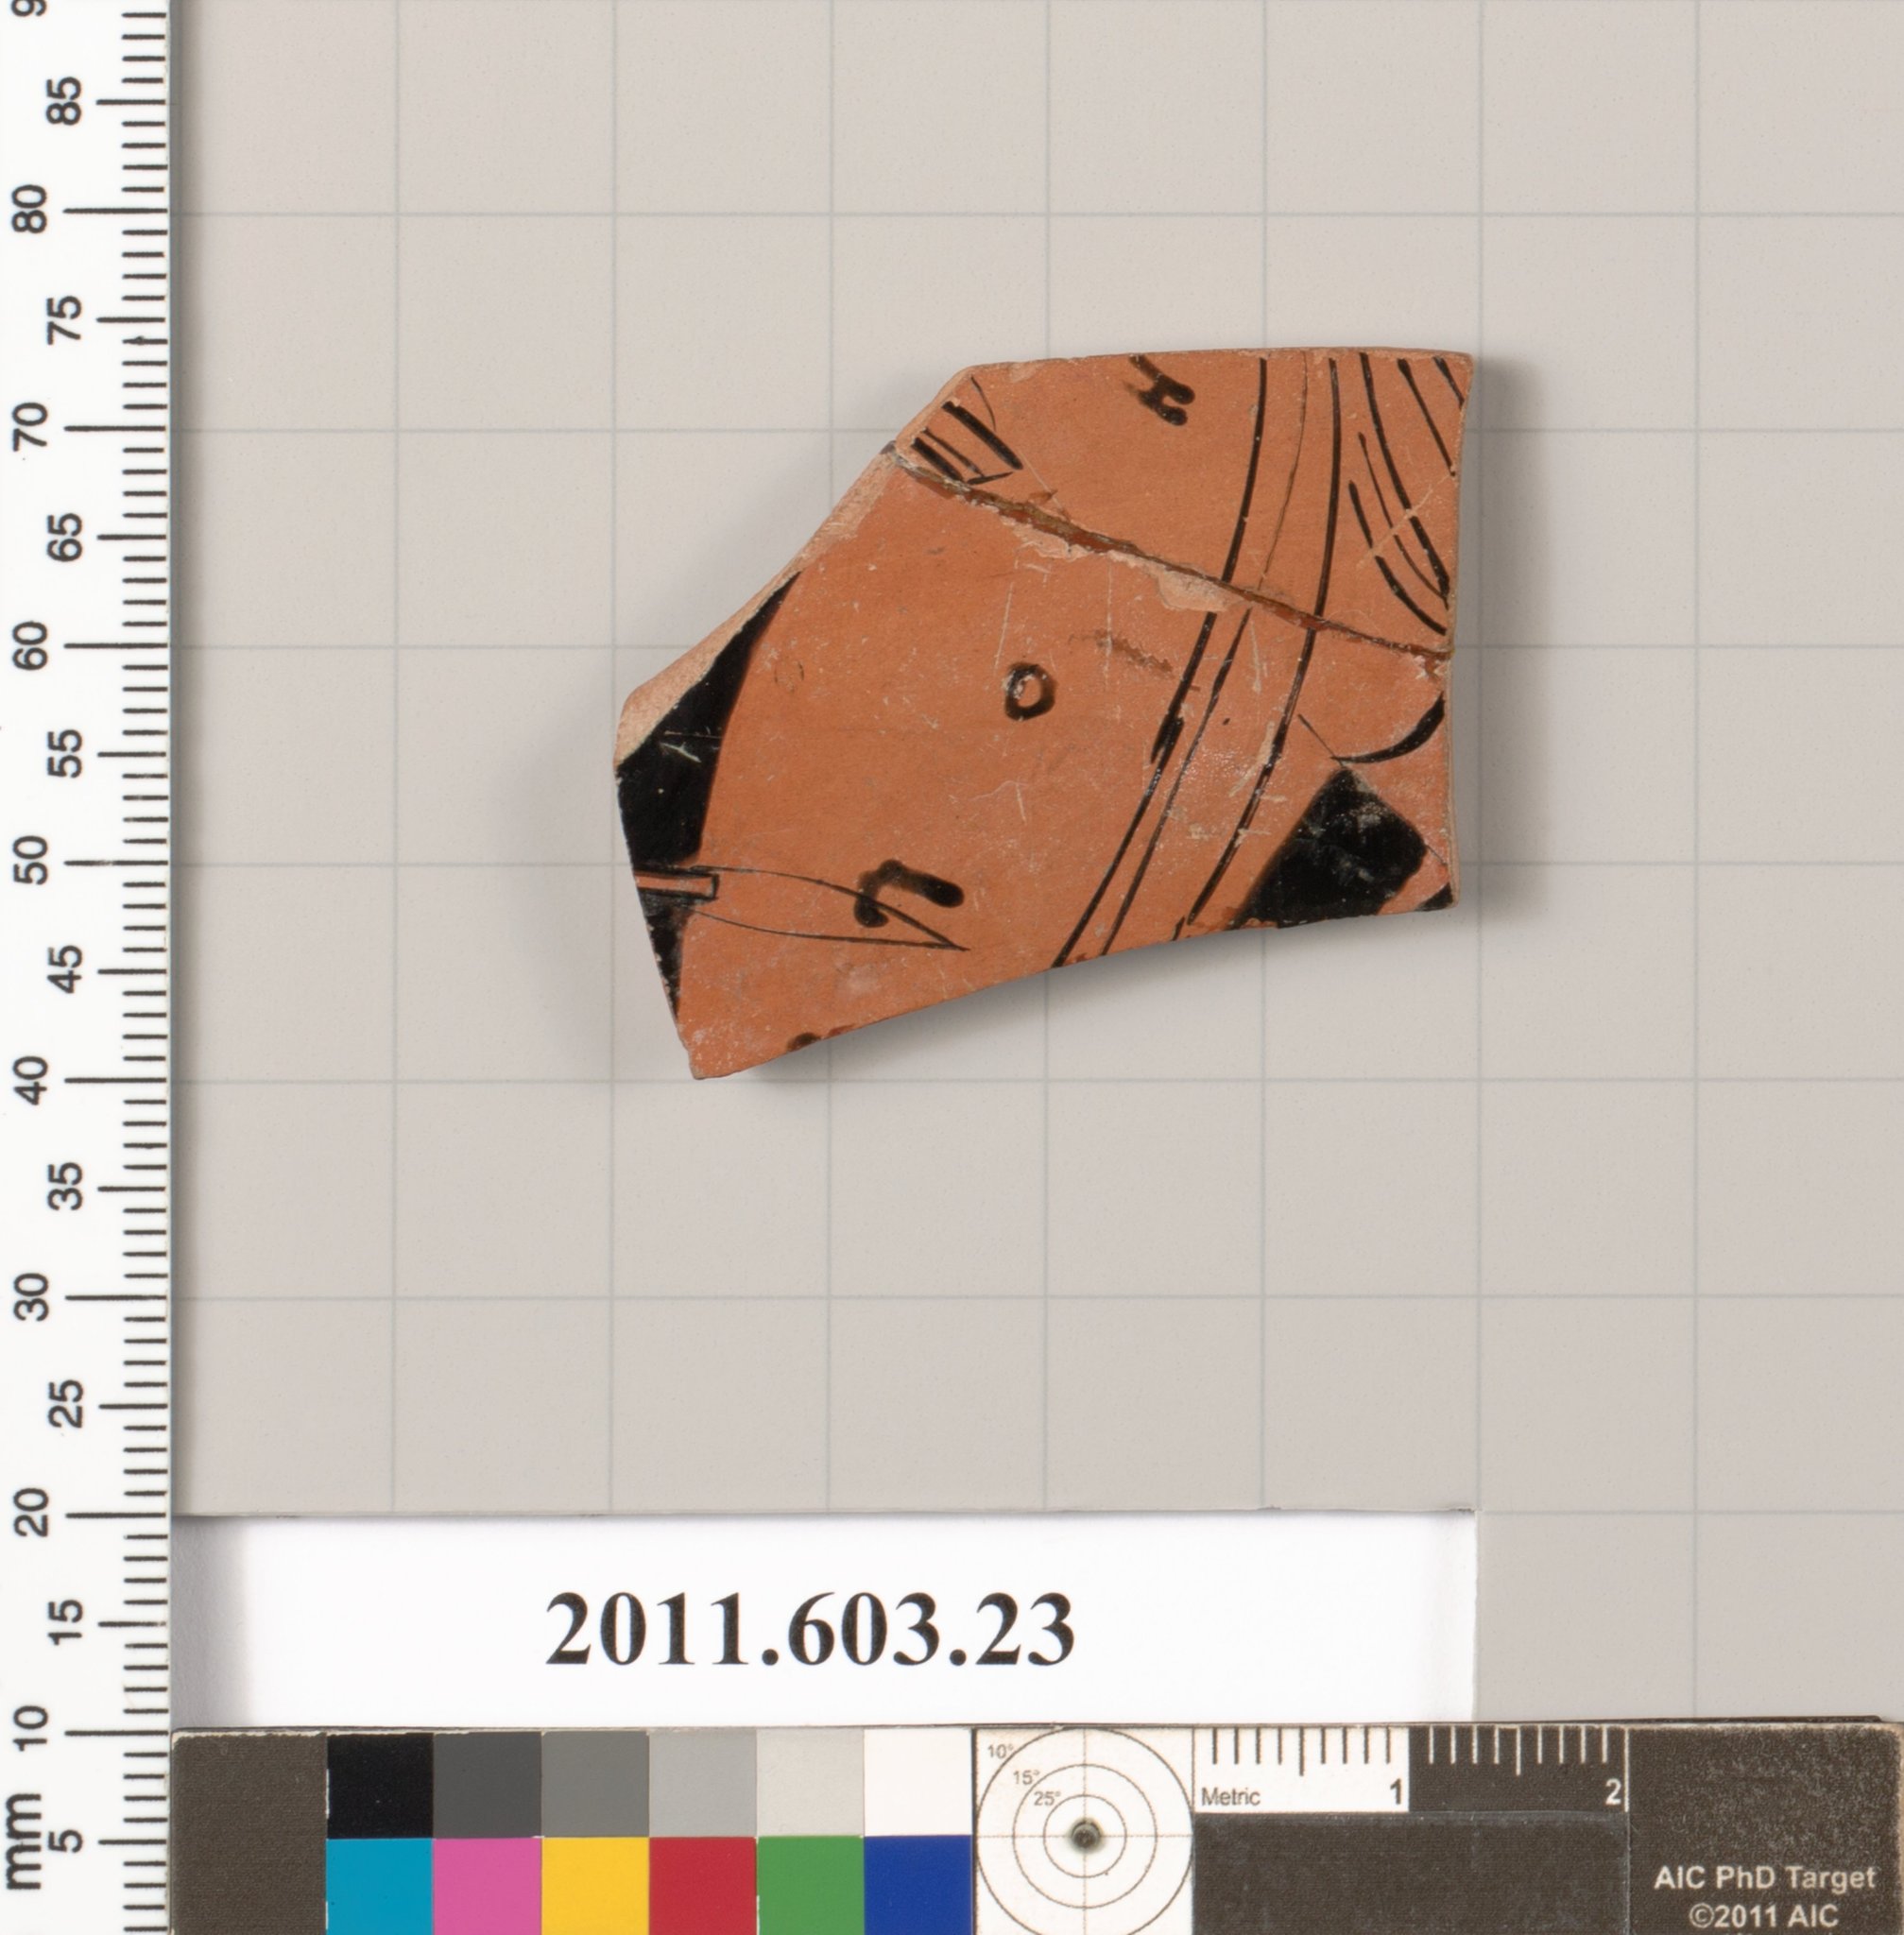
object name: kylix fragment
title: Fragment of a terracotta kylix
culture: greek, attic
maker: painter of berlin 2268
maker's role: artist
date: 525-501 BCE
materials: terracotta